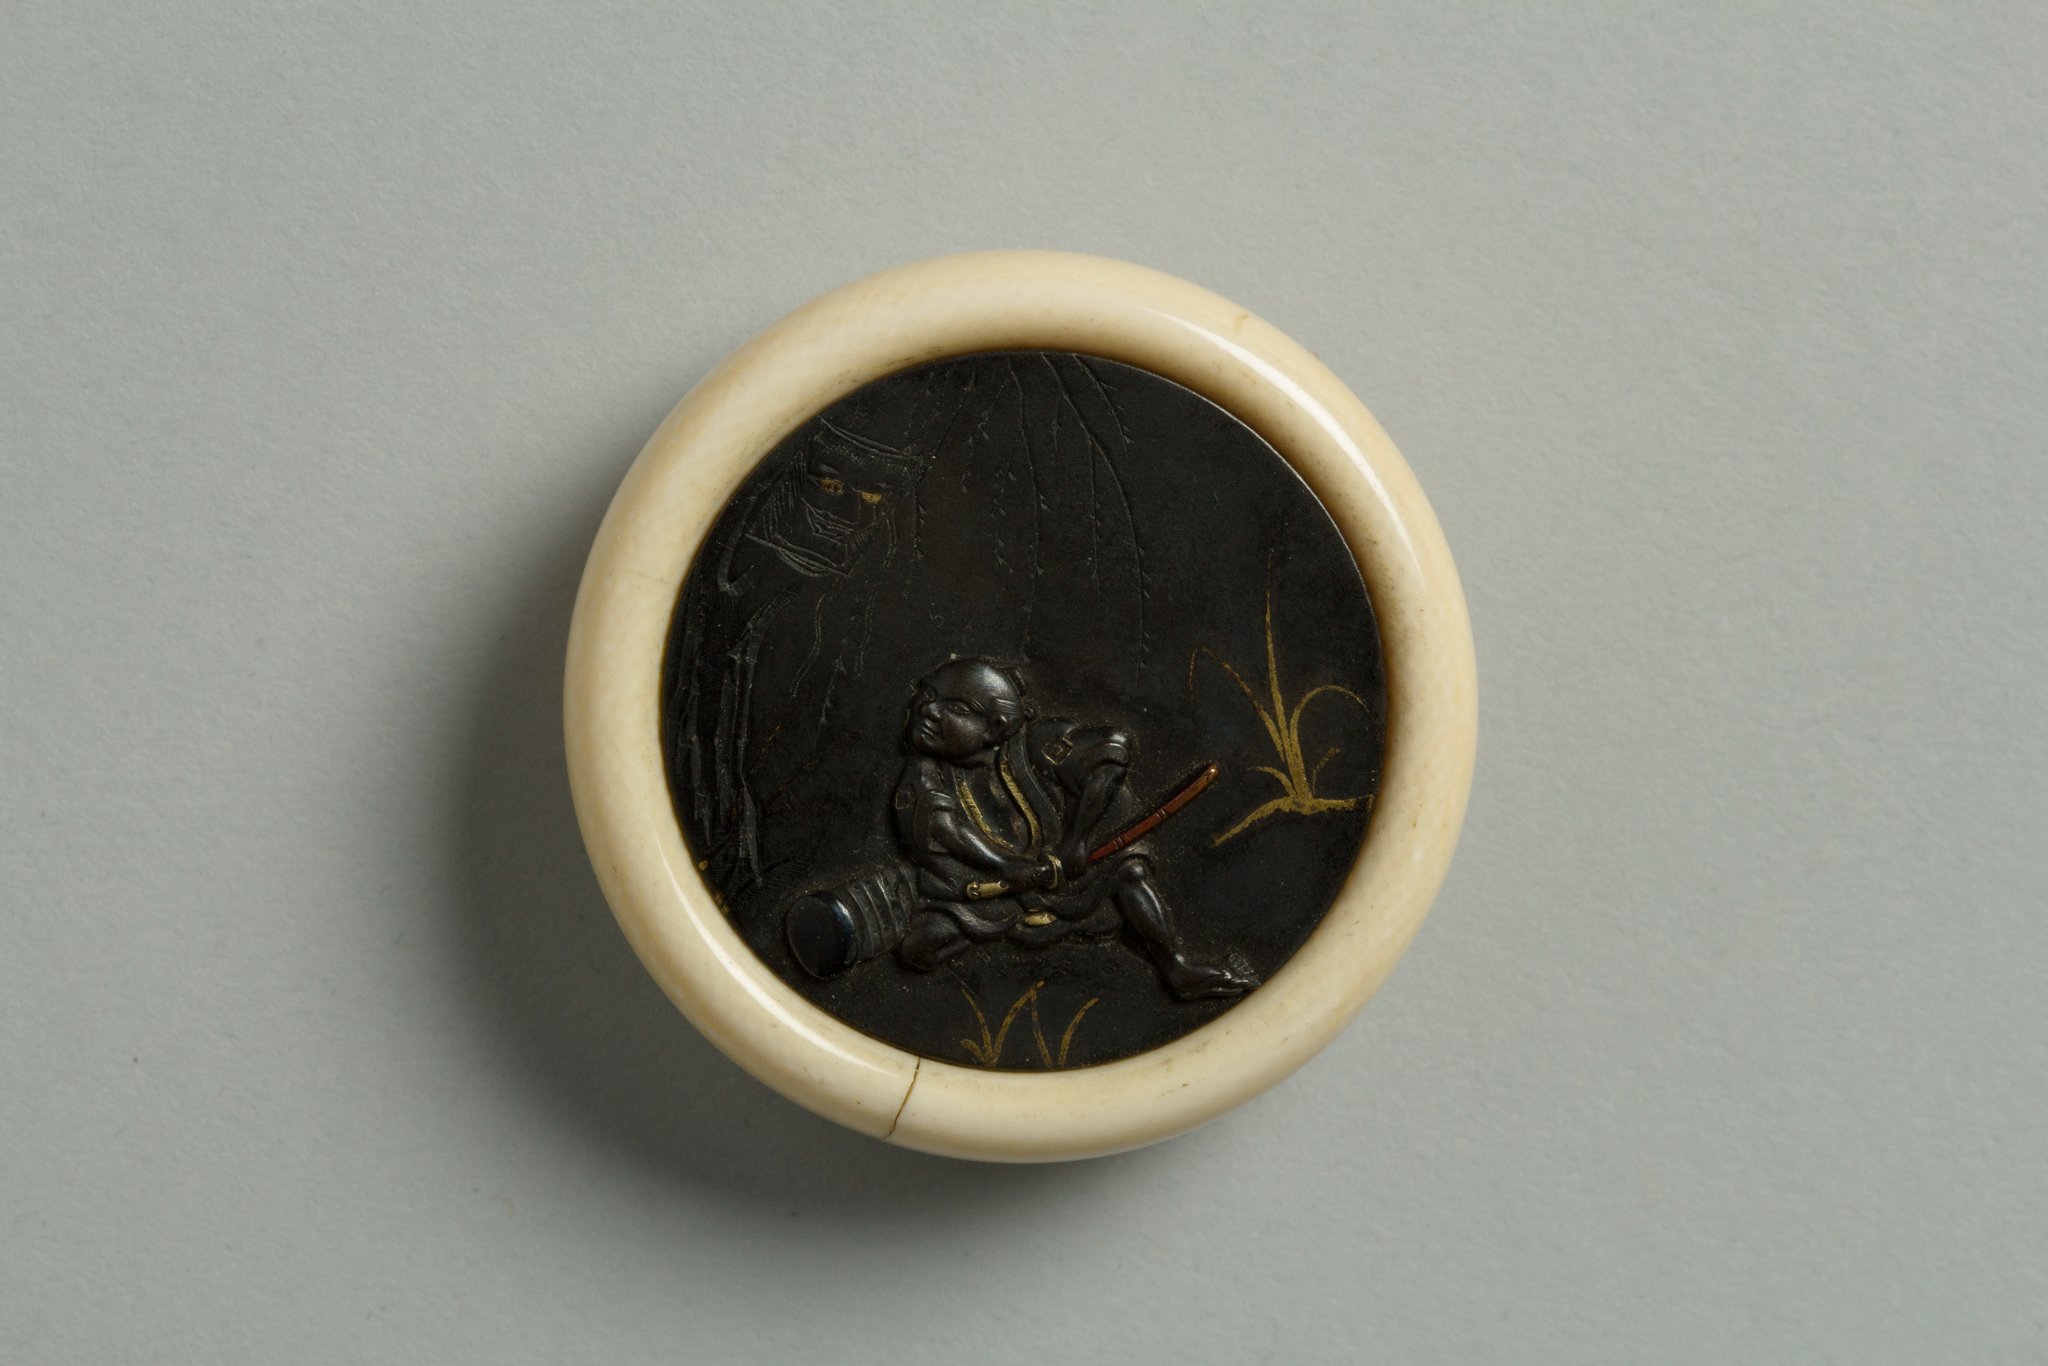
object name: netsuke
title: Bakemono Toro (lantern Bakemono)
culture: japanese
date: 1801-1900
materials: bronze, gold, ivory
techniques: inlay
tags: men